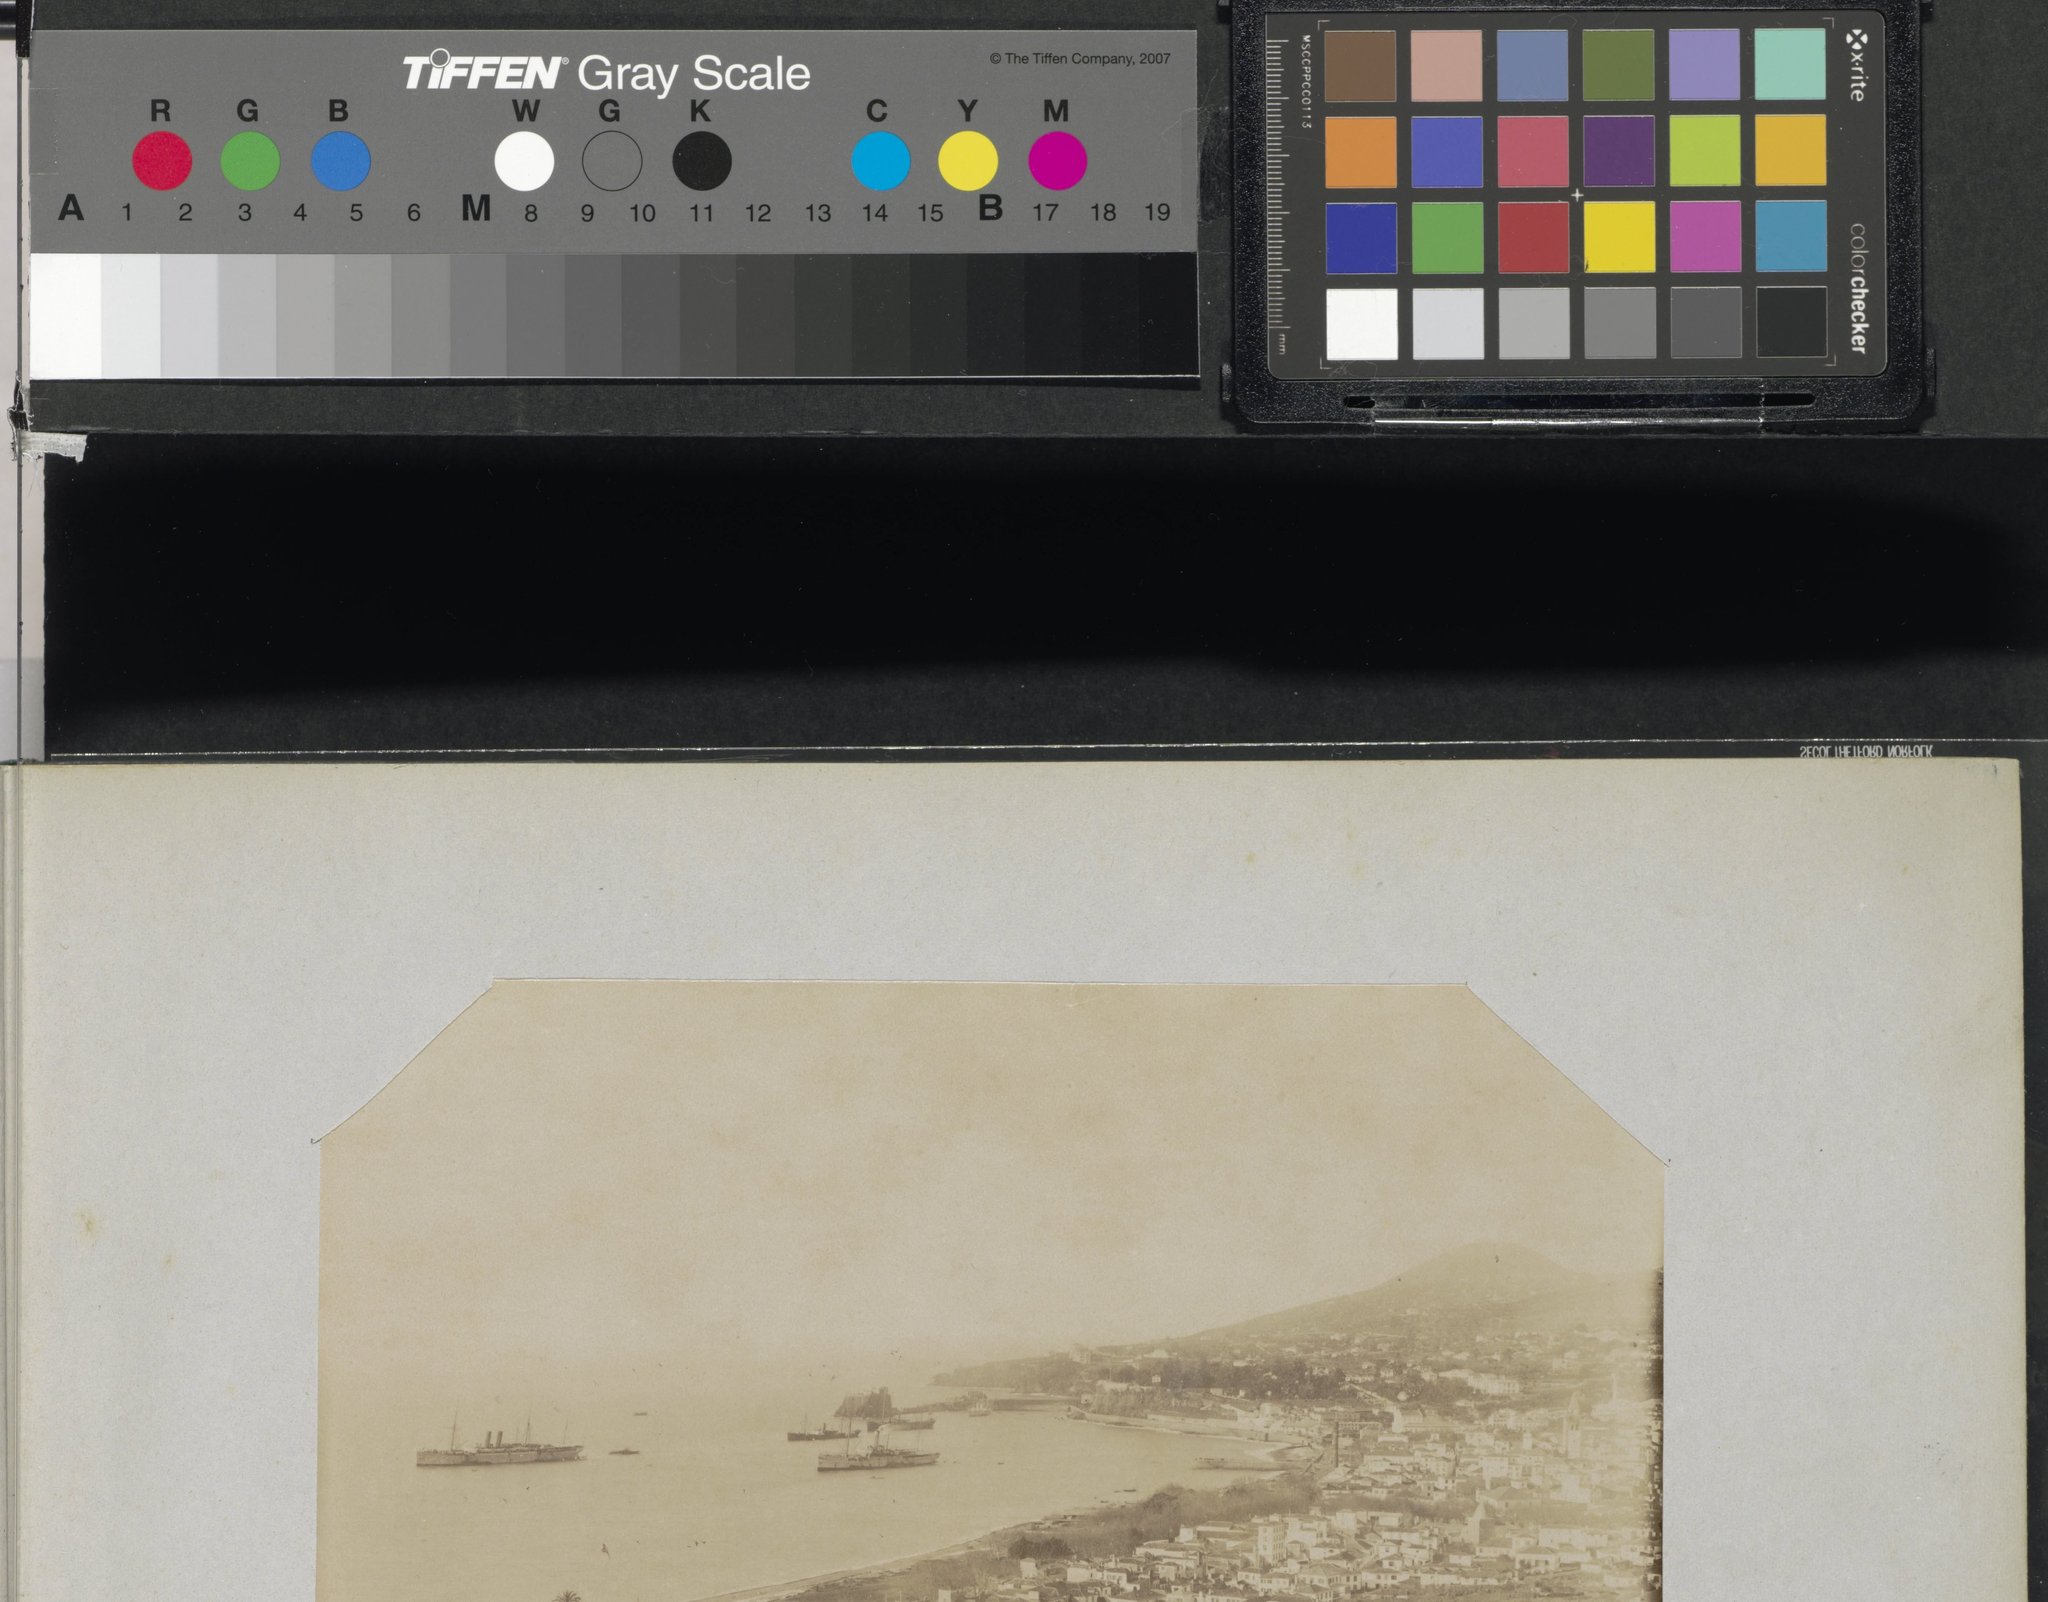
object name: photograph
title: Panorama van Madeira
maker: Anonymous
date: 1896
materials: photographic support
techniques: albumen print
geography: madeira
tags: harbour, city-view in general; 'veduta'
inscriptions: annotation: ‘Madeira Panorama, 15 Jan 1896. 12 Mei 1896’